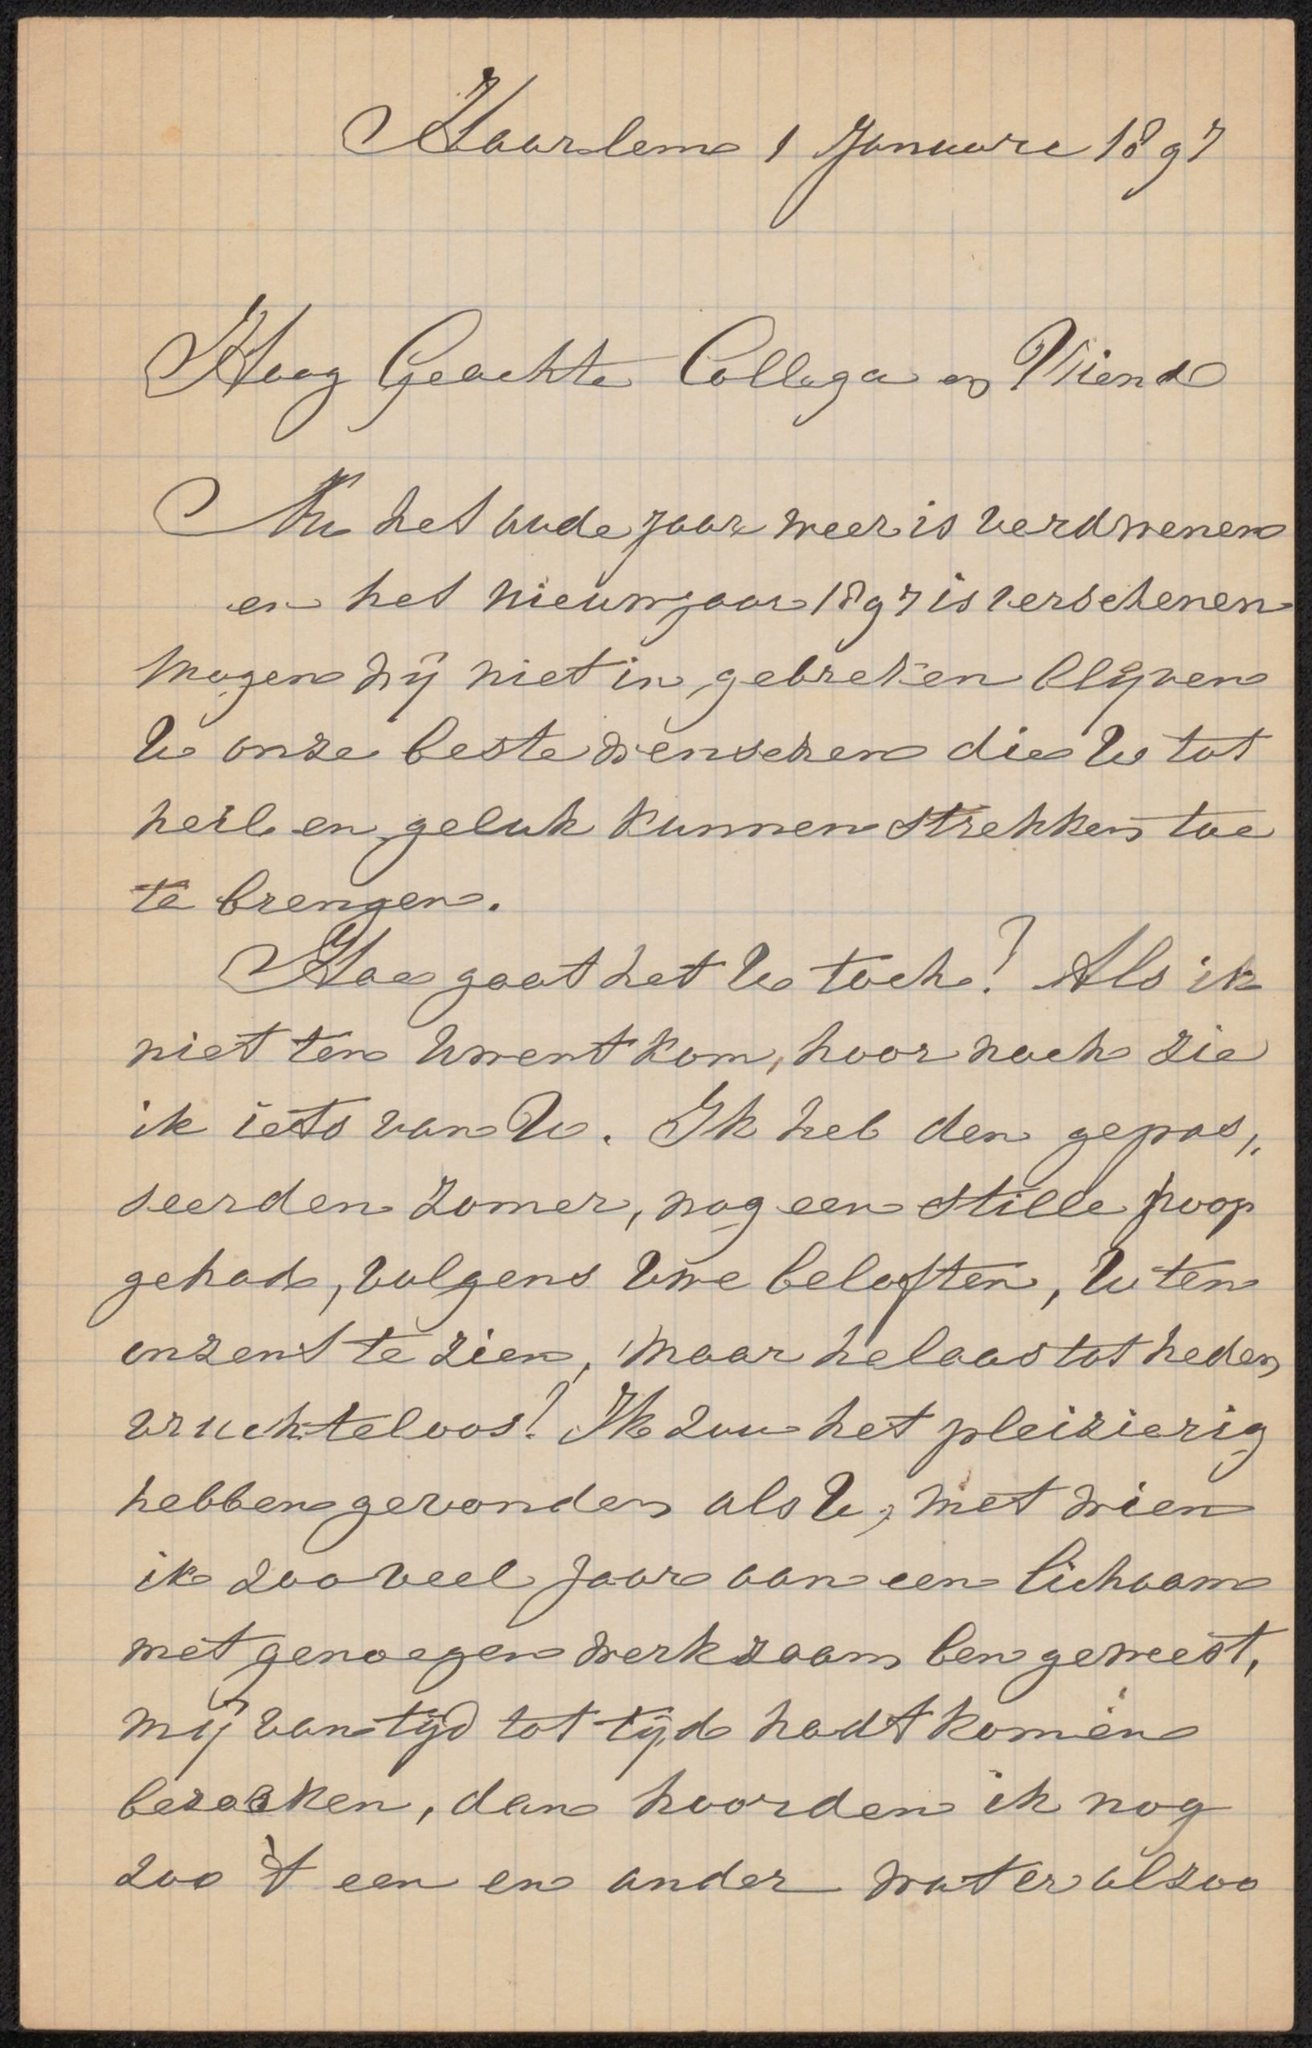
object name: letter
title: Brief aan August Allebé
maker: barend wijnveld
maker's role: draughtsman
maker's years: 1820-1902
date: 1897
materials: ink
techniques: pen, writing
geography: haarlem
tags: print maker, august allebé